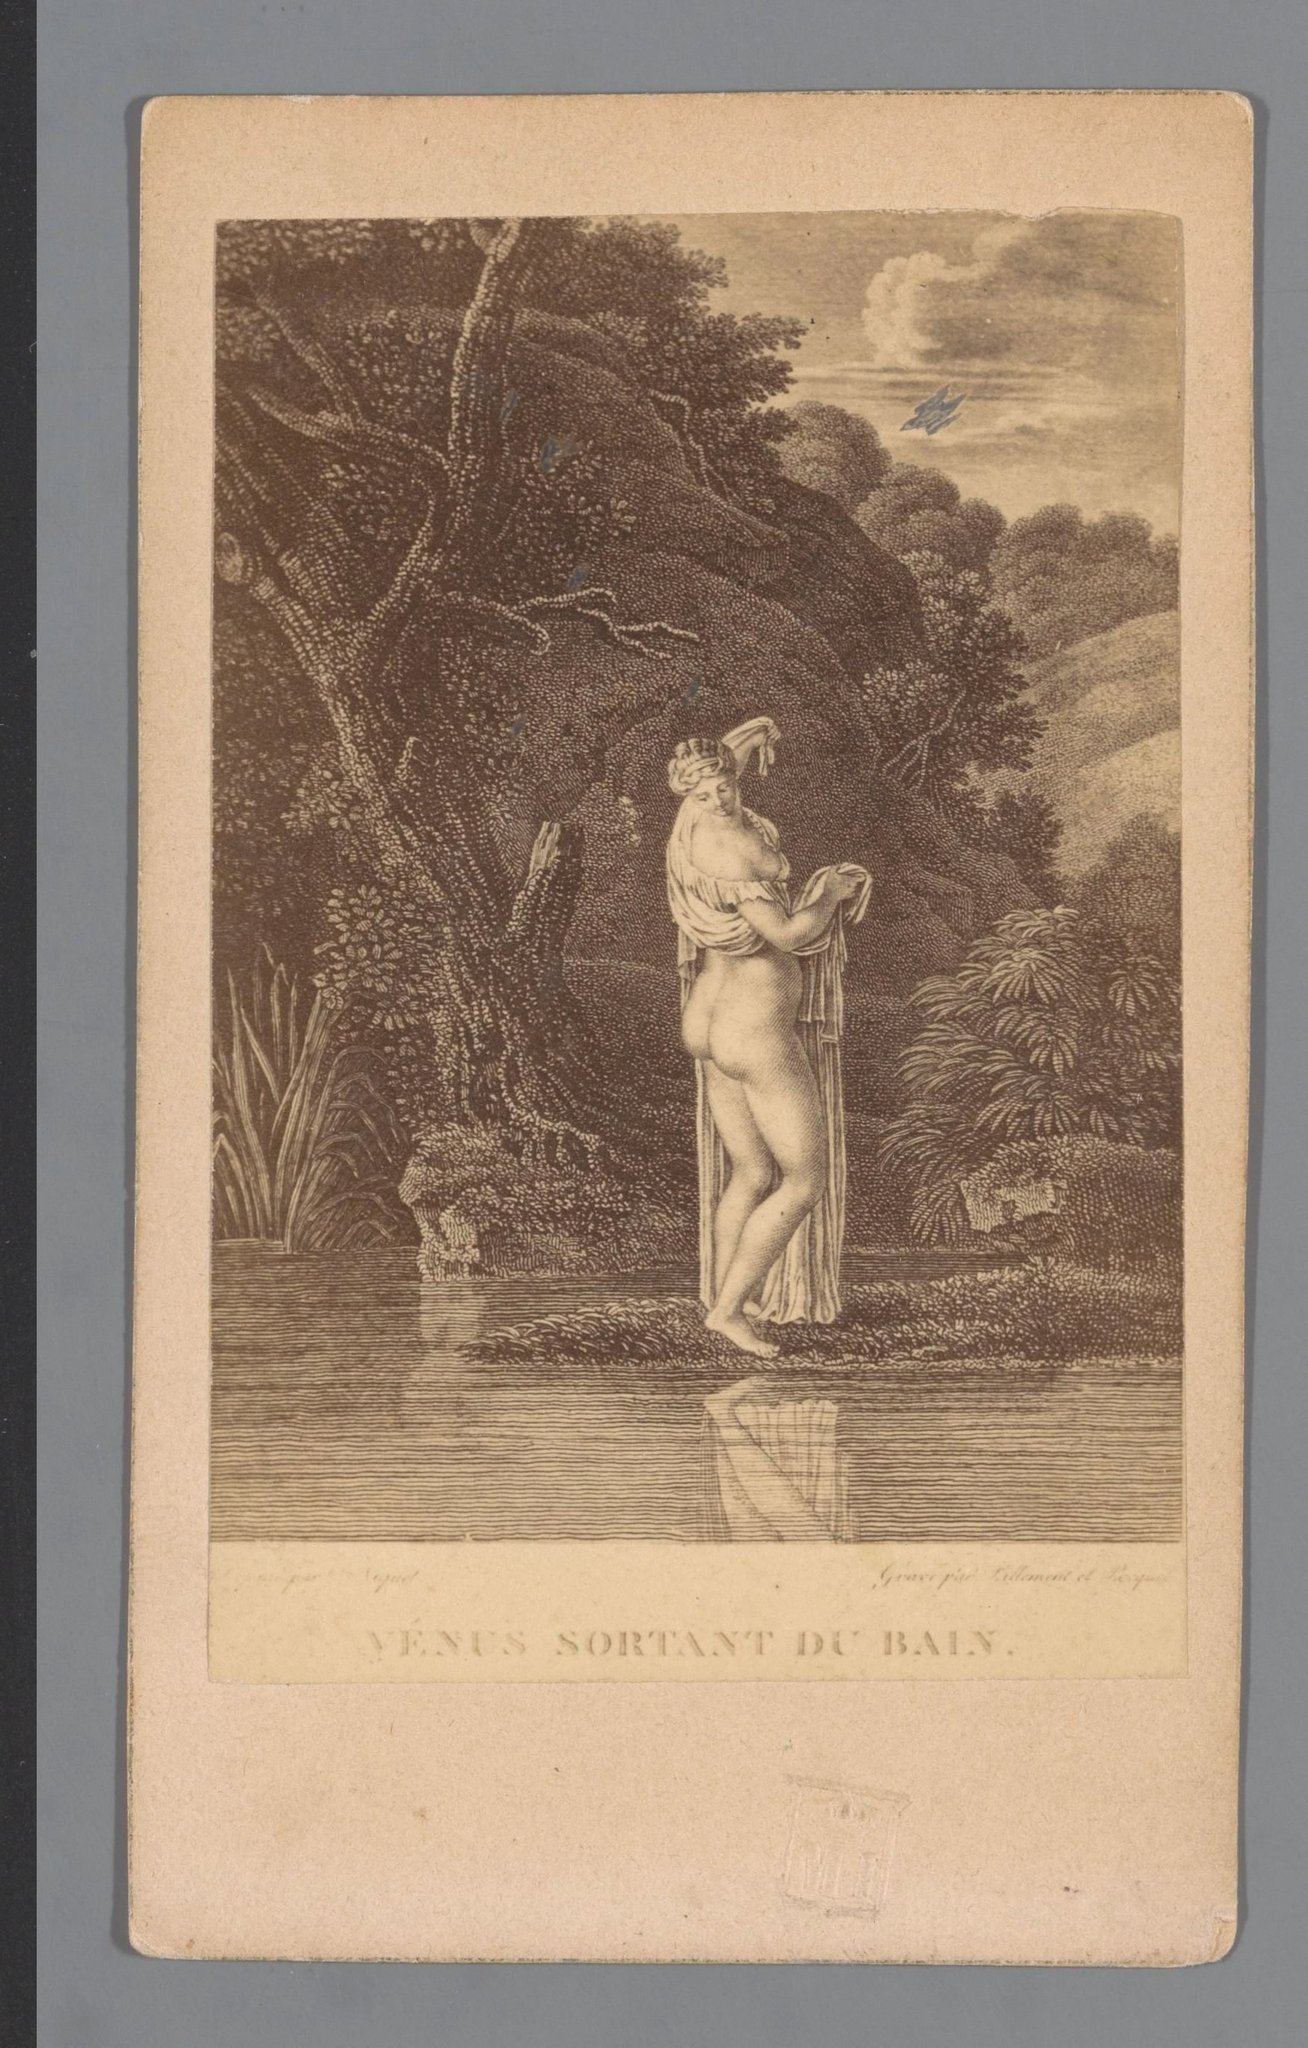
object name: photograph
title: Fotoreproductie van een gravure van Venus die uit het water stapt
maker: Anonymous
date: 1850-1900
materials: cardboard, photographic support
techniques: albumen print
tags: bath of venus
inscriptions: check stamp: ‘MI’